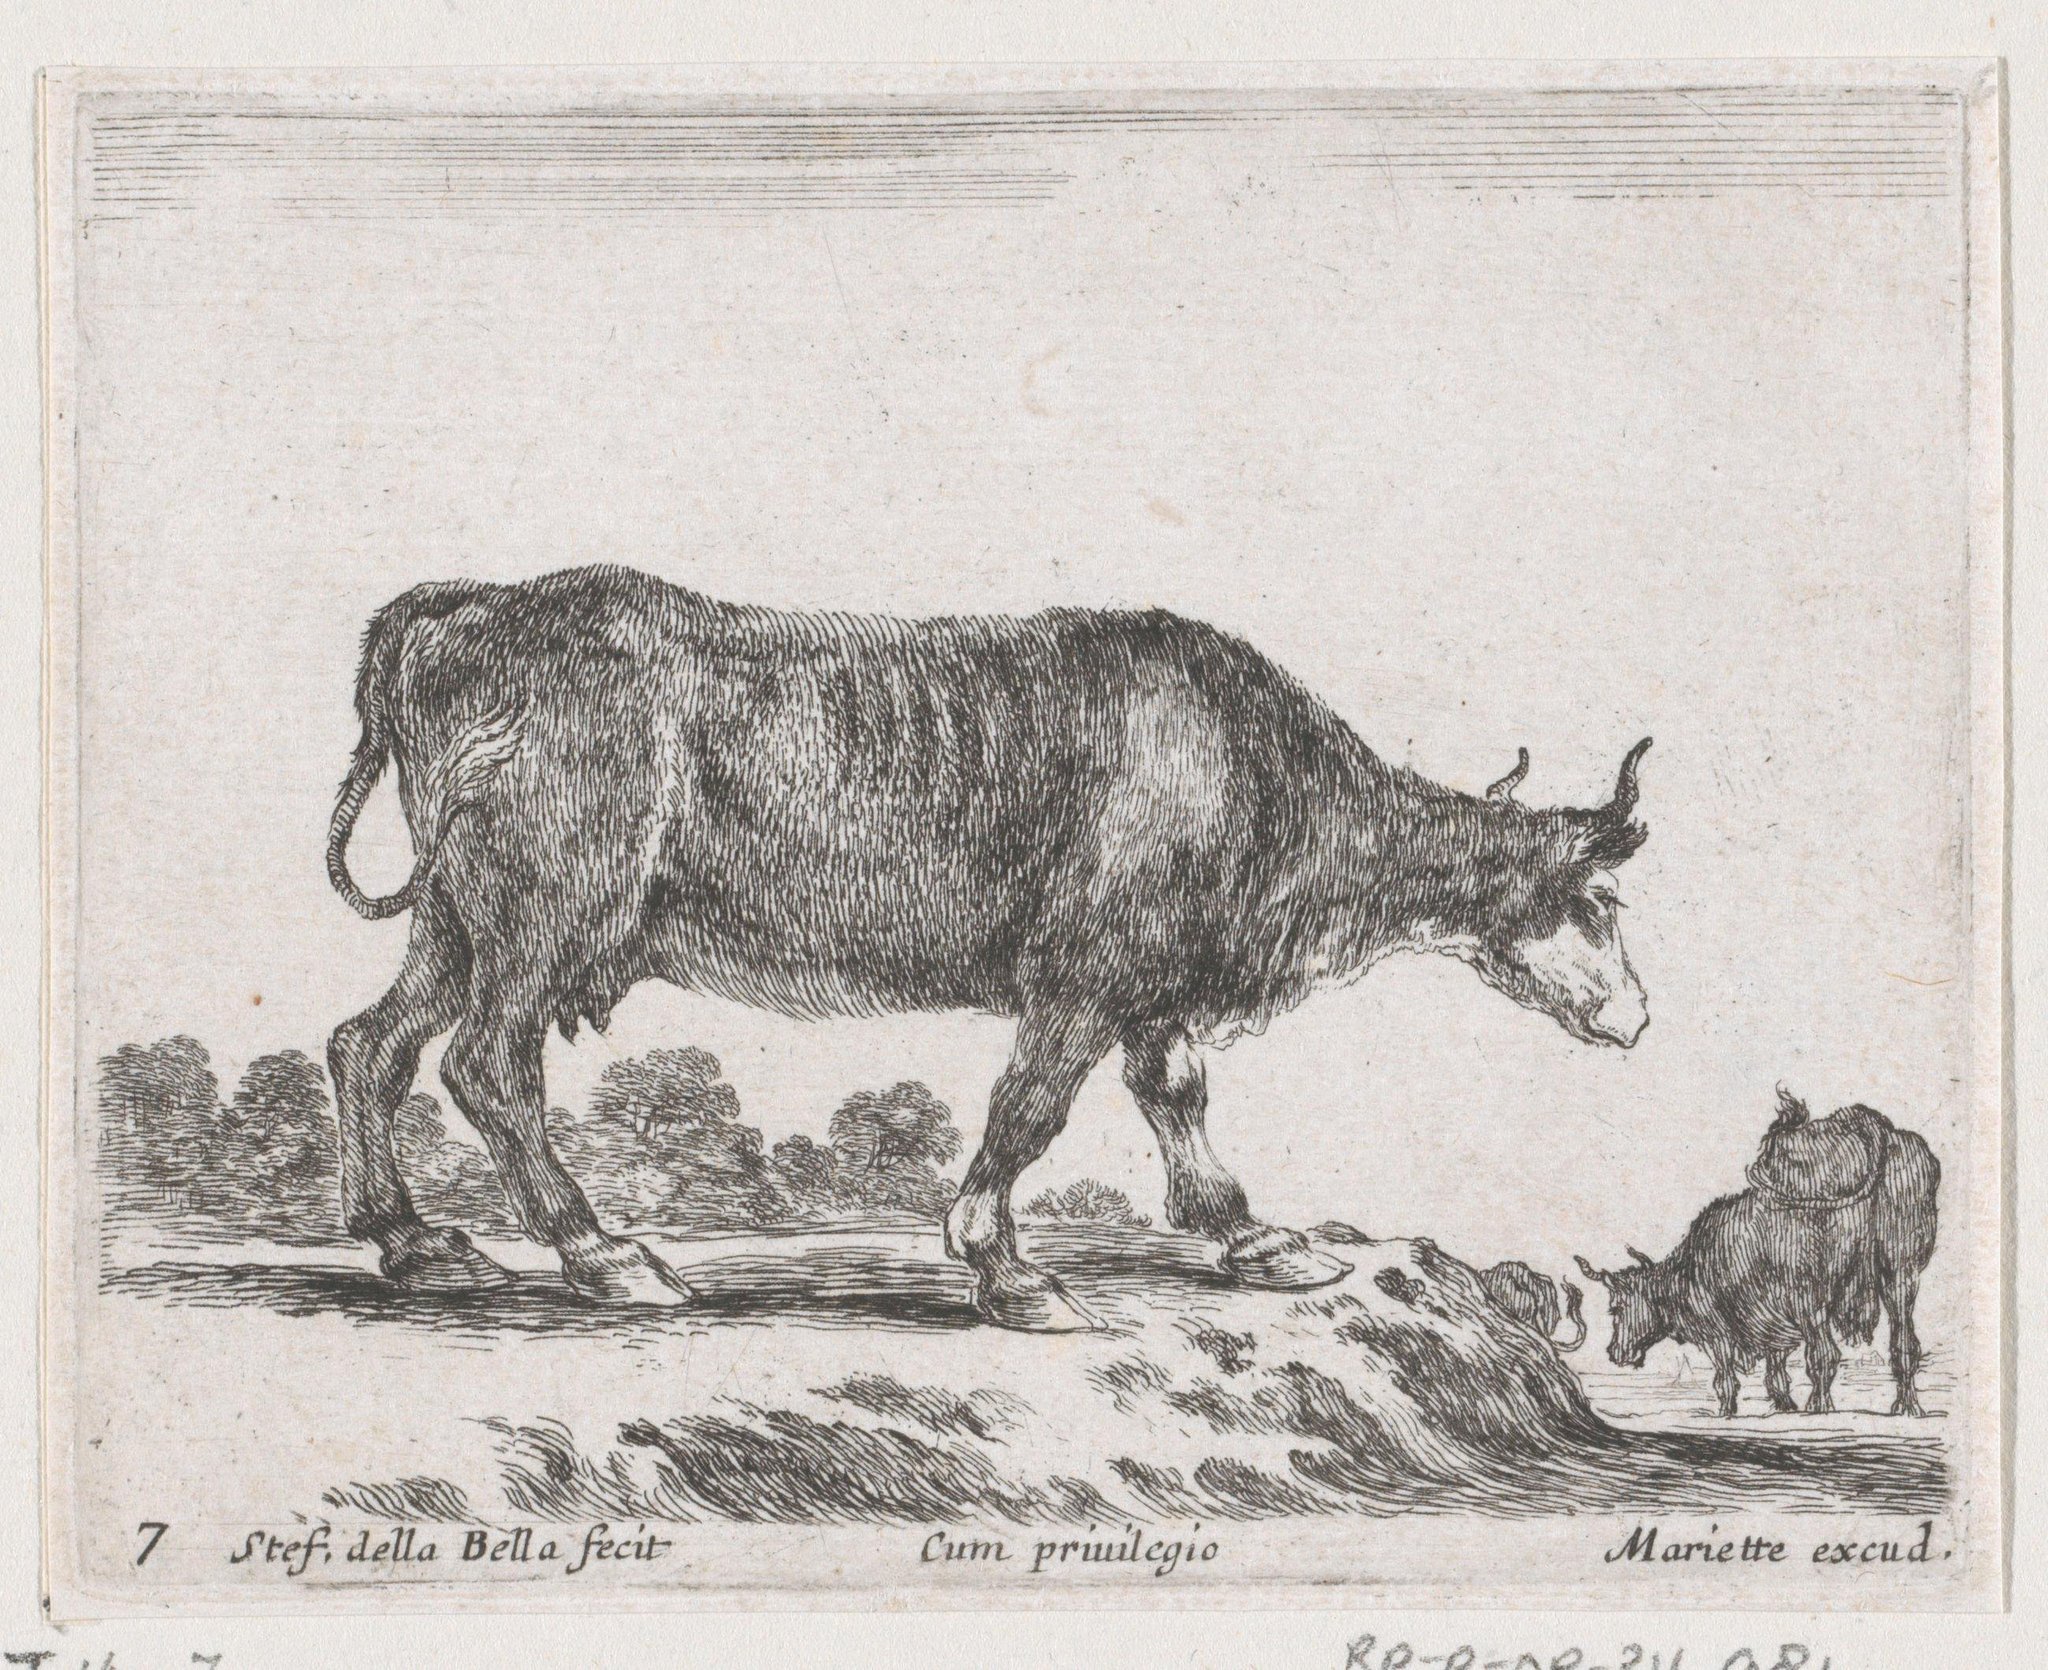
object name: print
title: Verschillende dieren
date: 1620-1664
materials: paper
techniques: etching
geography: paris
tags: cow, animals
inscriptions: collector's mark: Lugt 240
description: Een staande koe in een landschap. Op de achtergrond rechts een tweede koe, van achteren gezien.